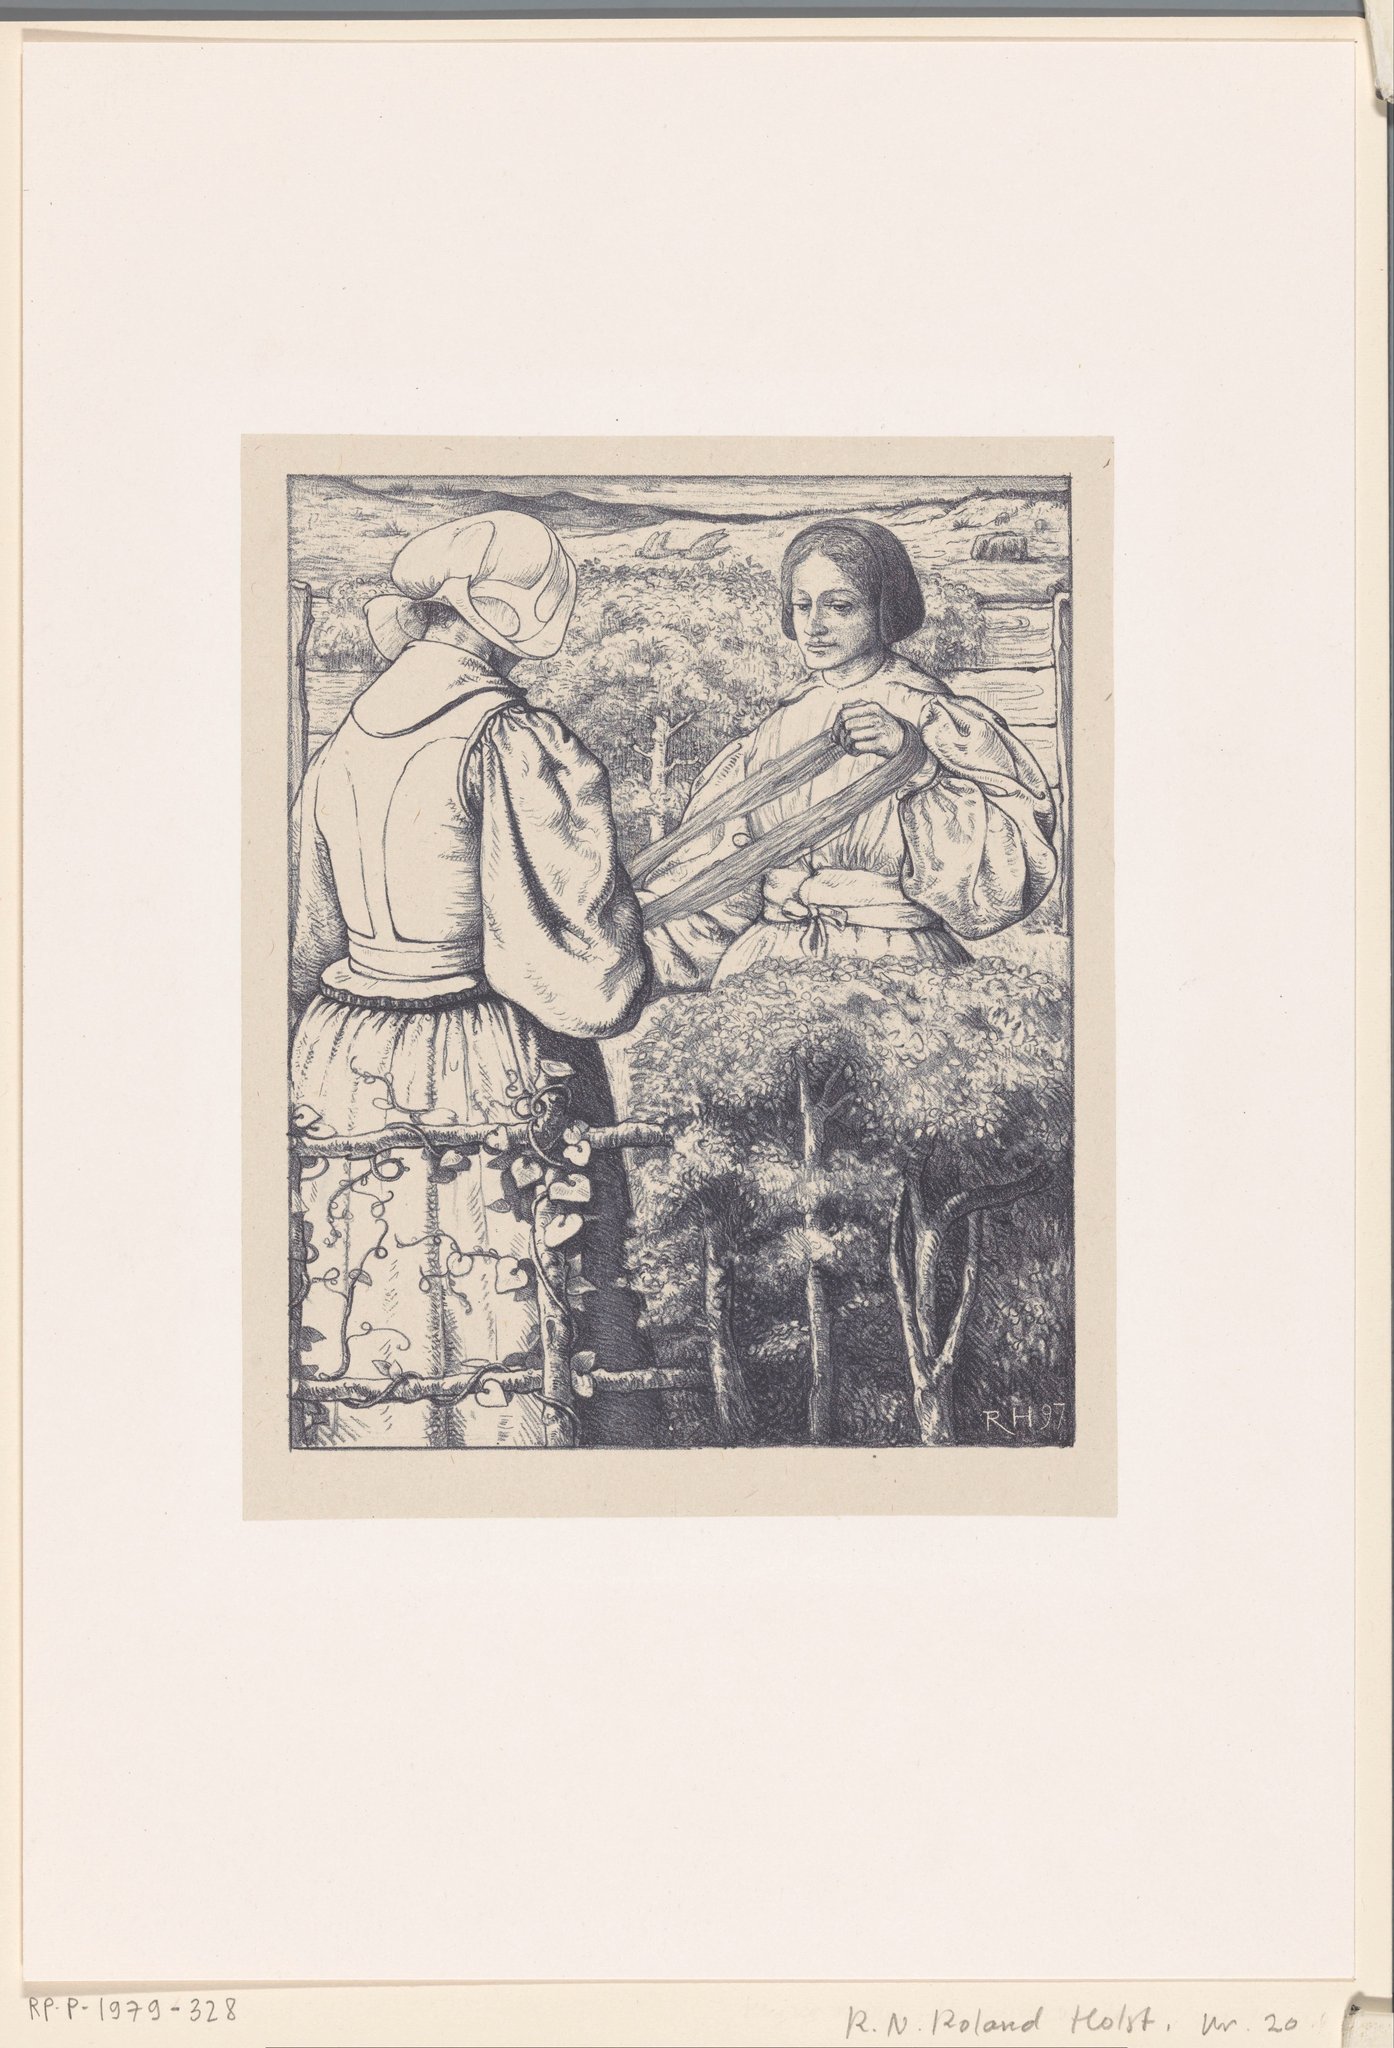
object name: print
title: Huizer meisjes die garen winden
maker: richard nicolaüs roland holst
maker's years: 1868-1938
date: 1897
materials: paper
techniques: lithograph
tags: low hill country, winding of yarn, folk costume, regional costume, child (at home) - aa - girl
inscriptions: number: ‘12’, collector's mark: Lugt 2228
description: Twee meisjes in Huizer klederdracht winden samen garen in een tuin. Op de achtergrond een heuvellandschap.